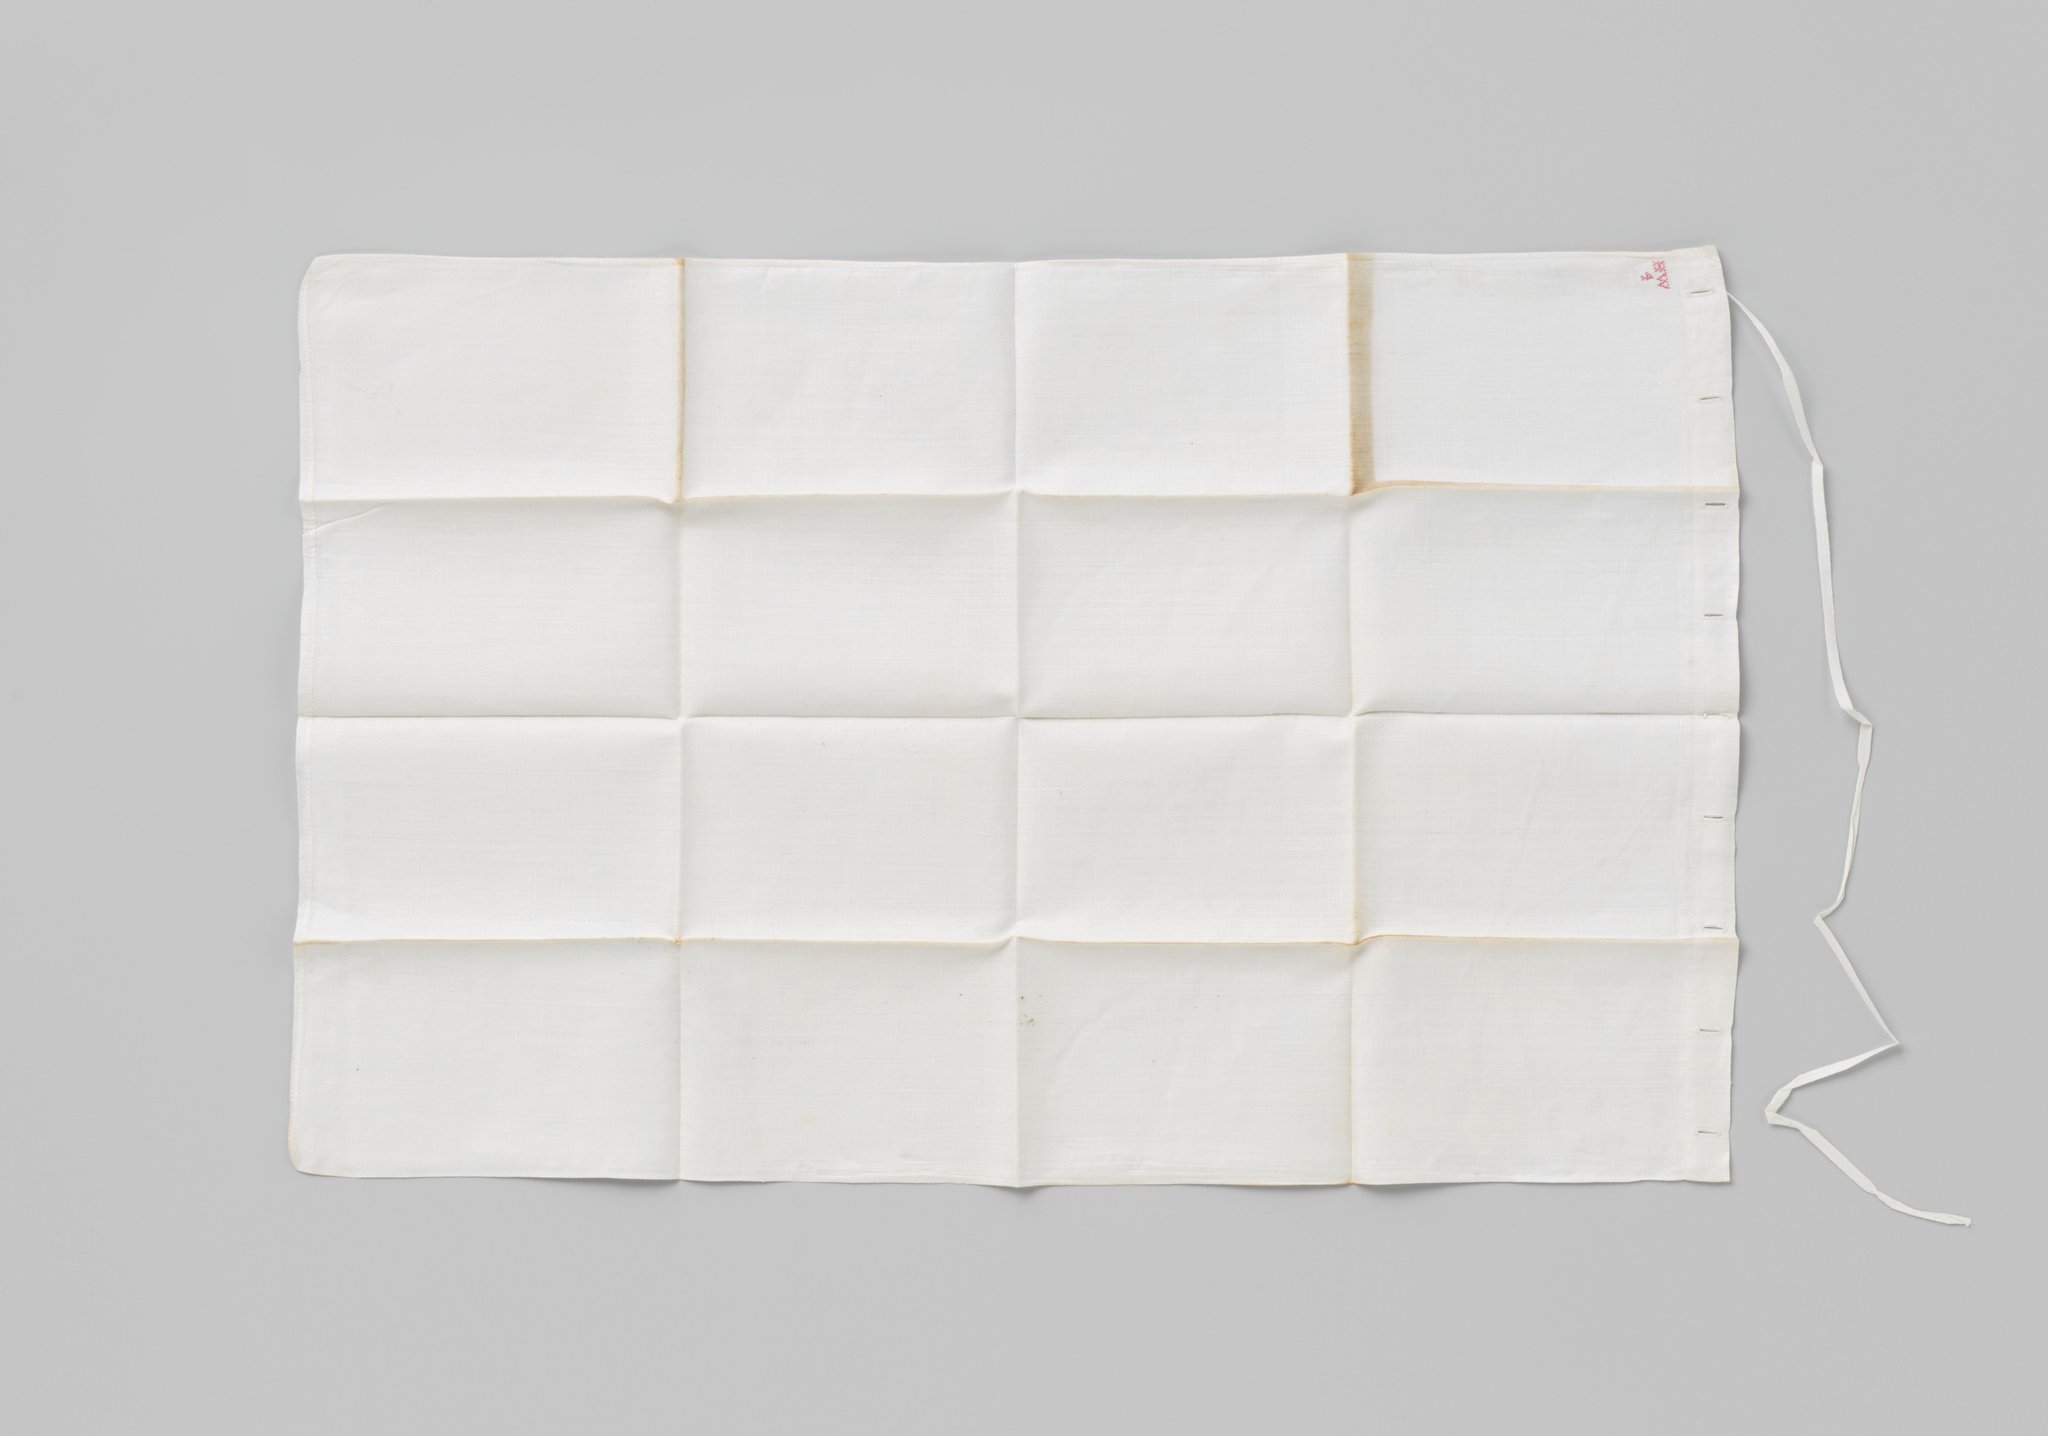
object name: lendensloop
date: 1692-1735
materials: linen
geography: northern netherlands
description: Lendensloop van linnen, merk kroon GS24 en HW4.